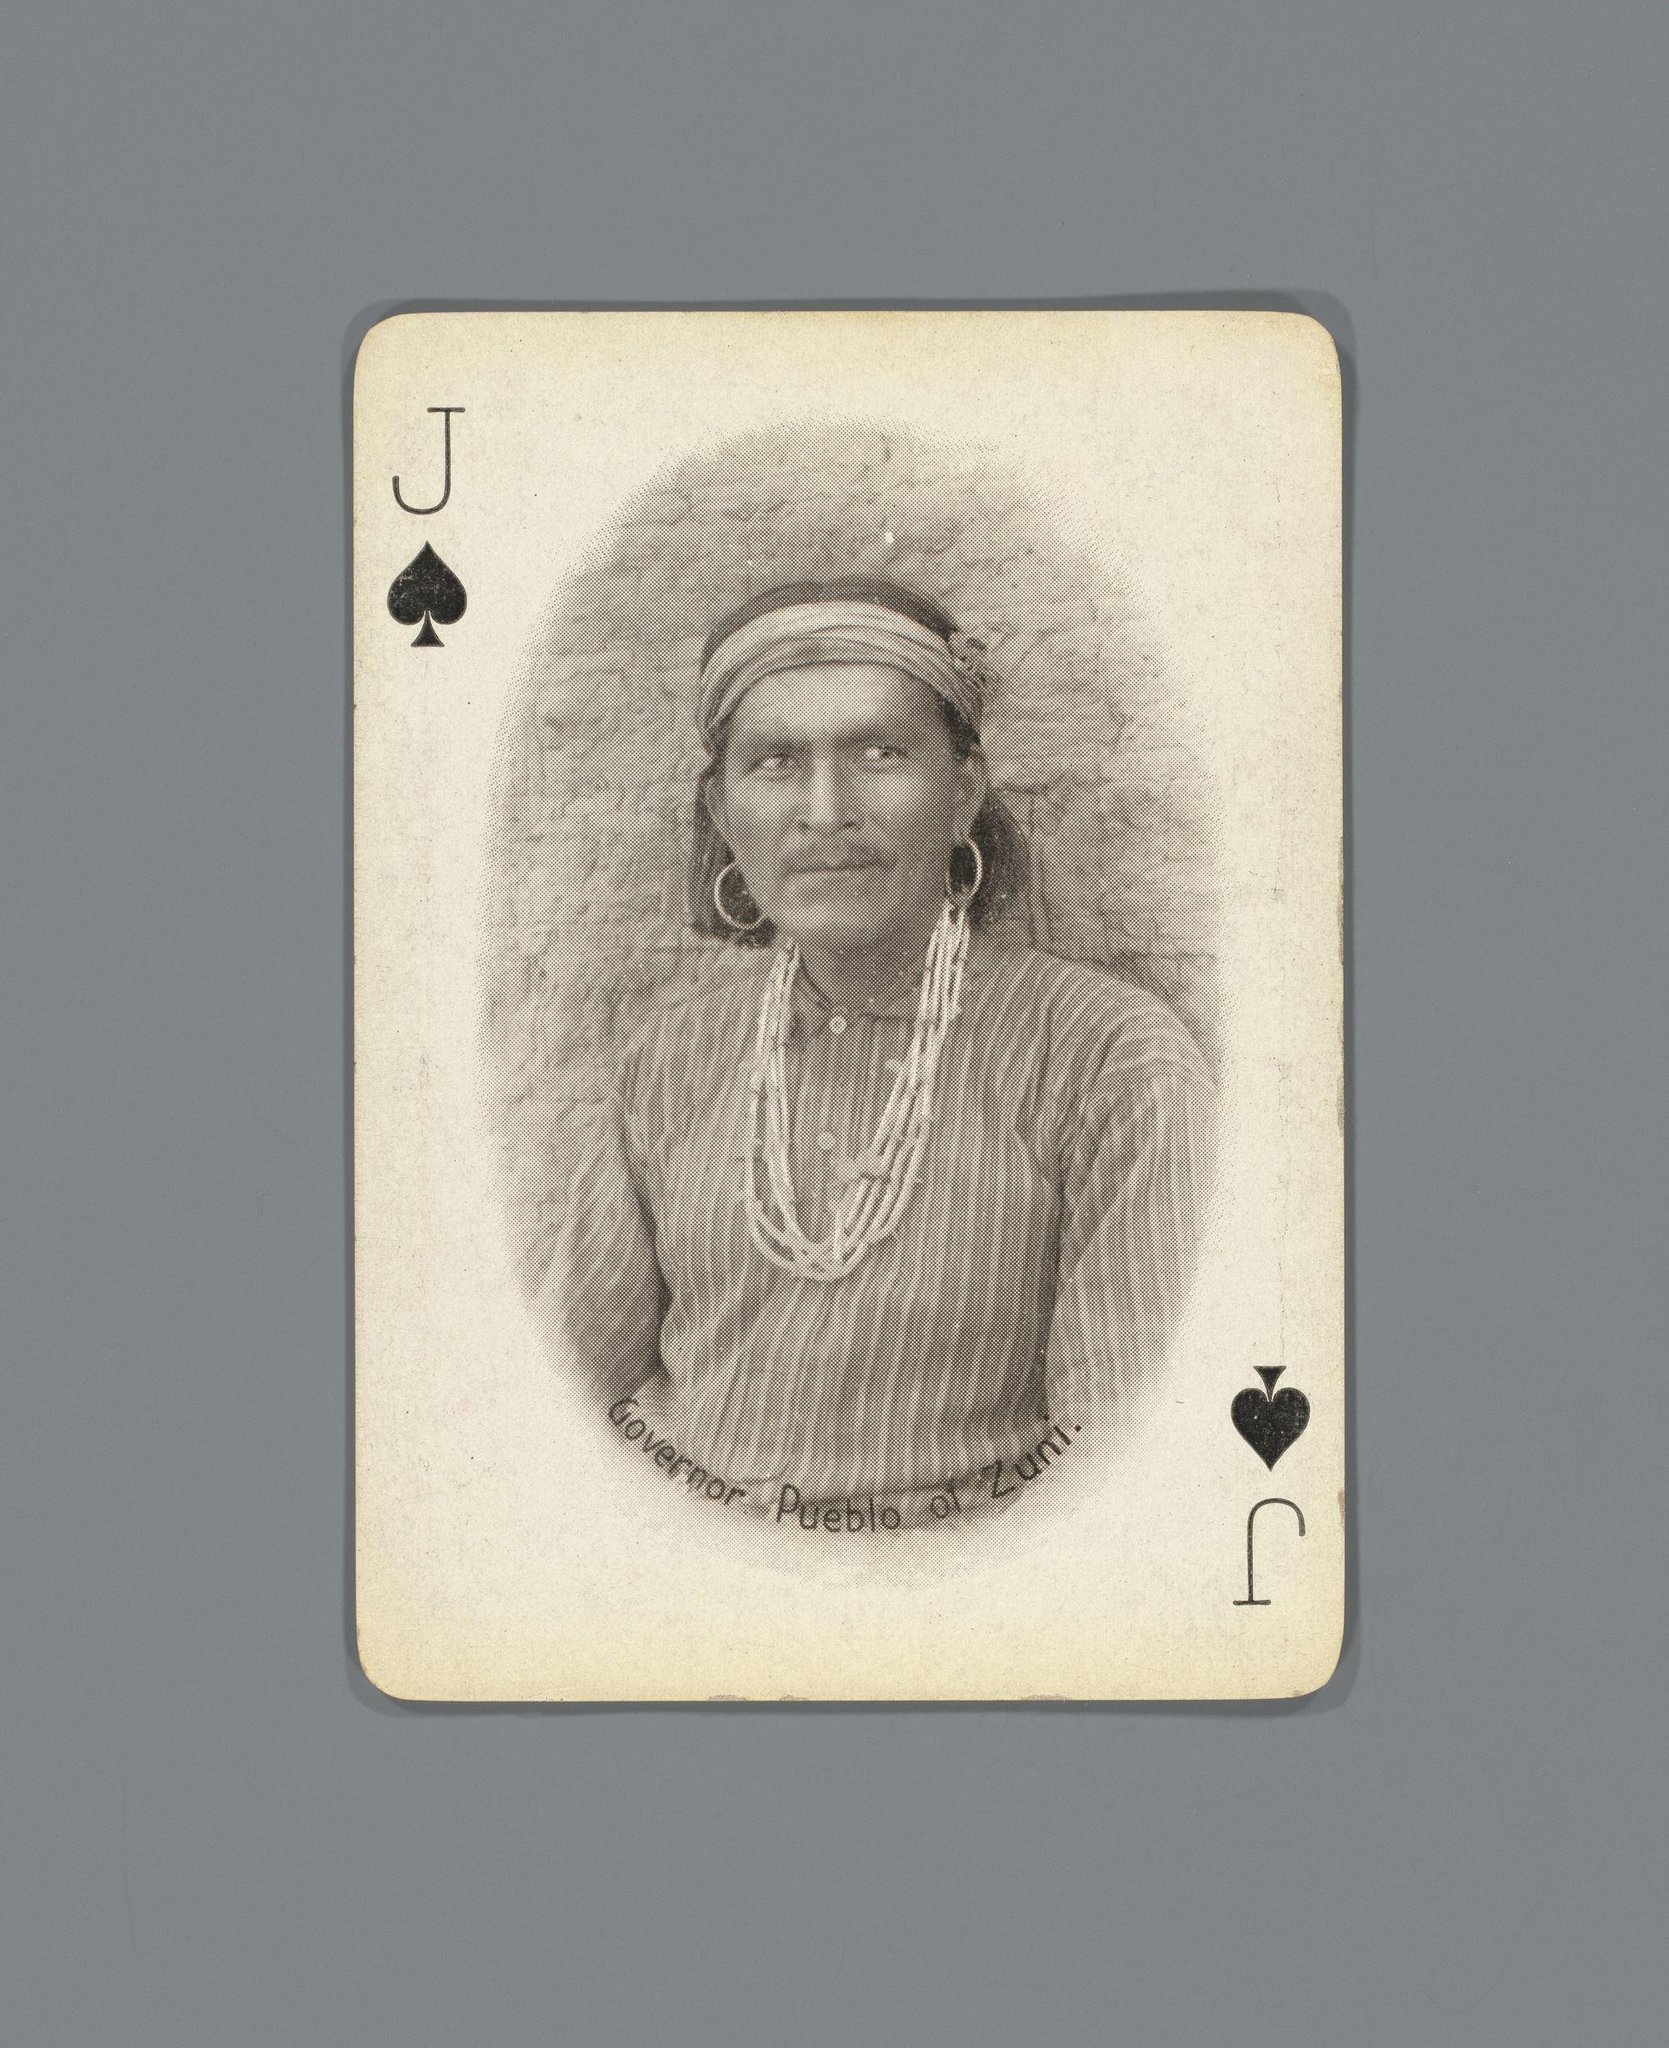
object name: playing card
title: Governor Pueblo of Zuni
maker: adam clark vroman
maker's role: fotograaf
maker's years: 1856-1916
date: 1900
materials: paper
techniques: autotype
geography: united states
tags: united states of america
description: Speelkaart uit doosje met 53 speelkaarten met afbeeldingen in autotypie van Native Americans. De inhoud bevat een complete set speelkaarten inclusief joker.